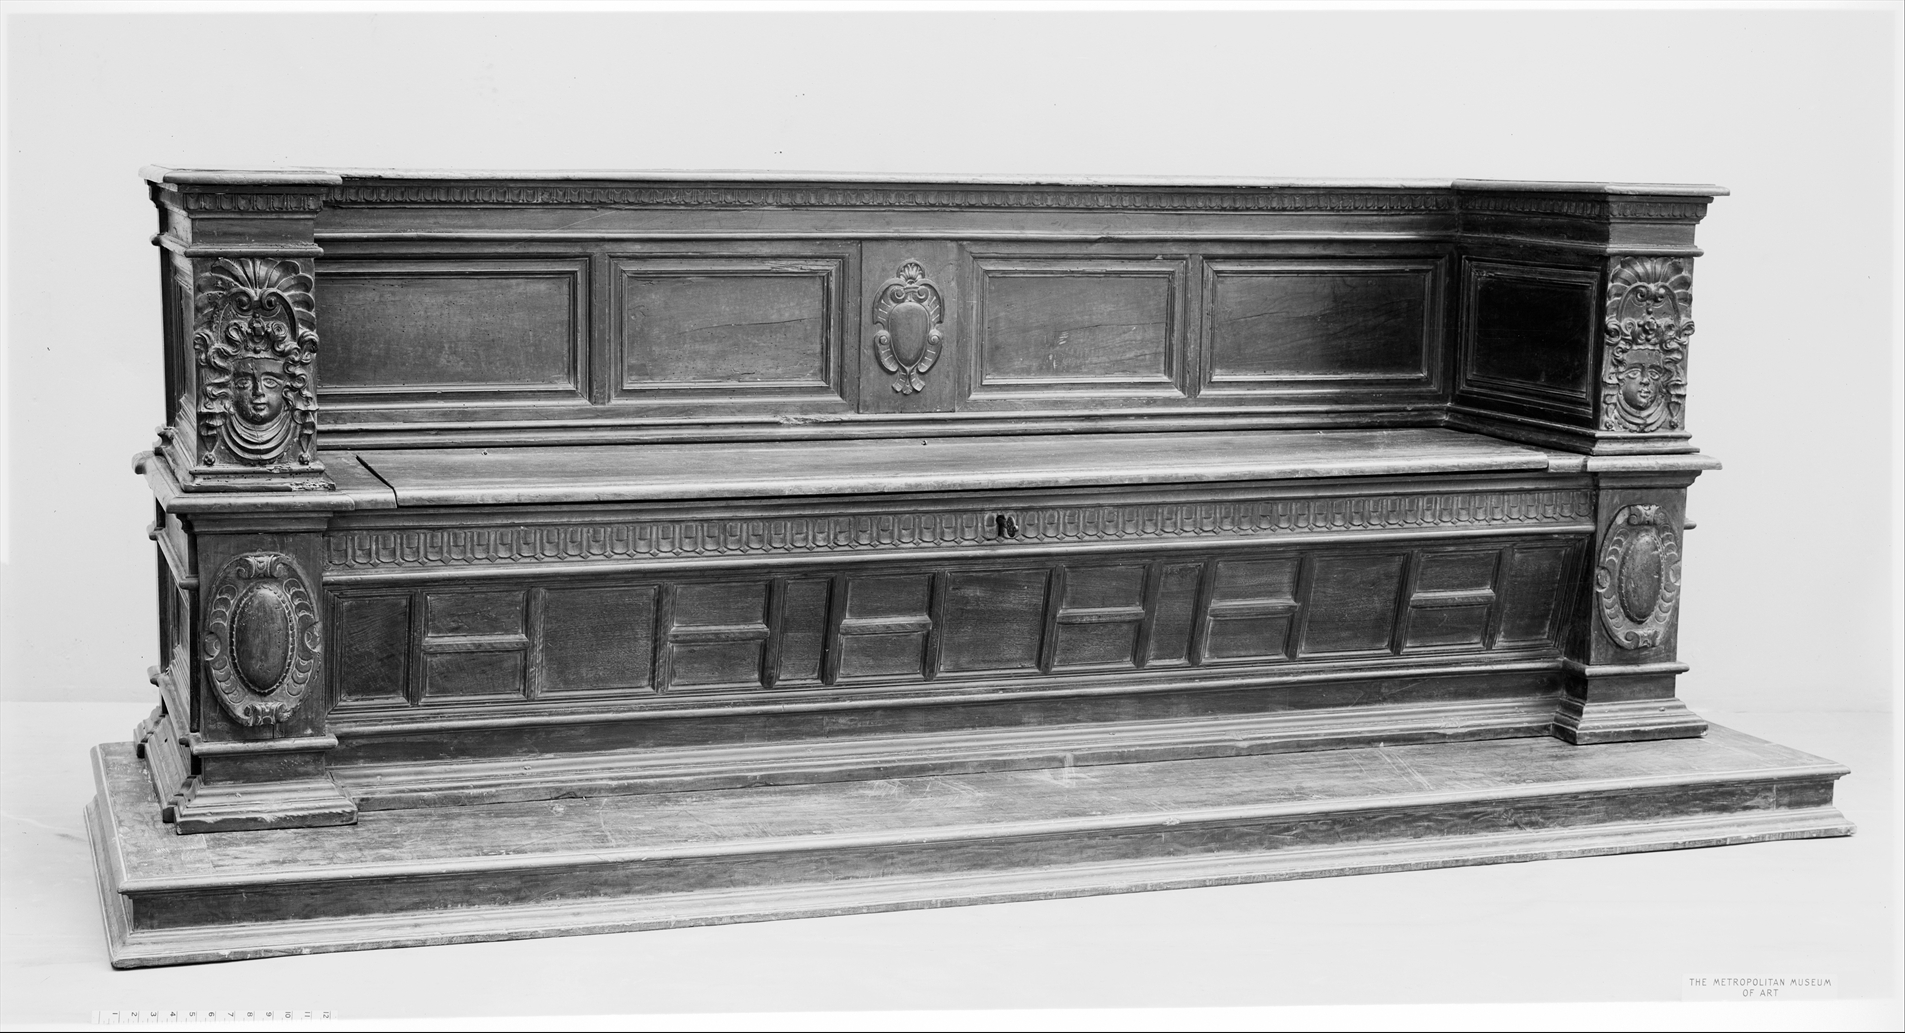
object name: bench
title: Bench (cassapanca)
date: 1534-1566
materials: wood